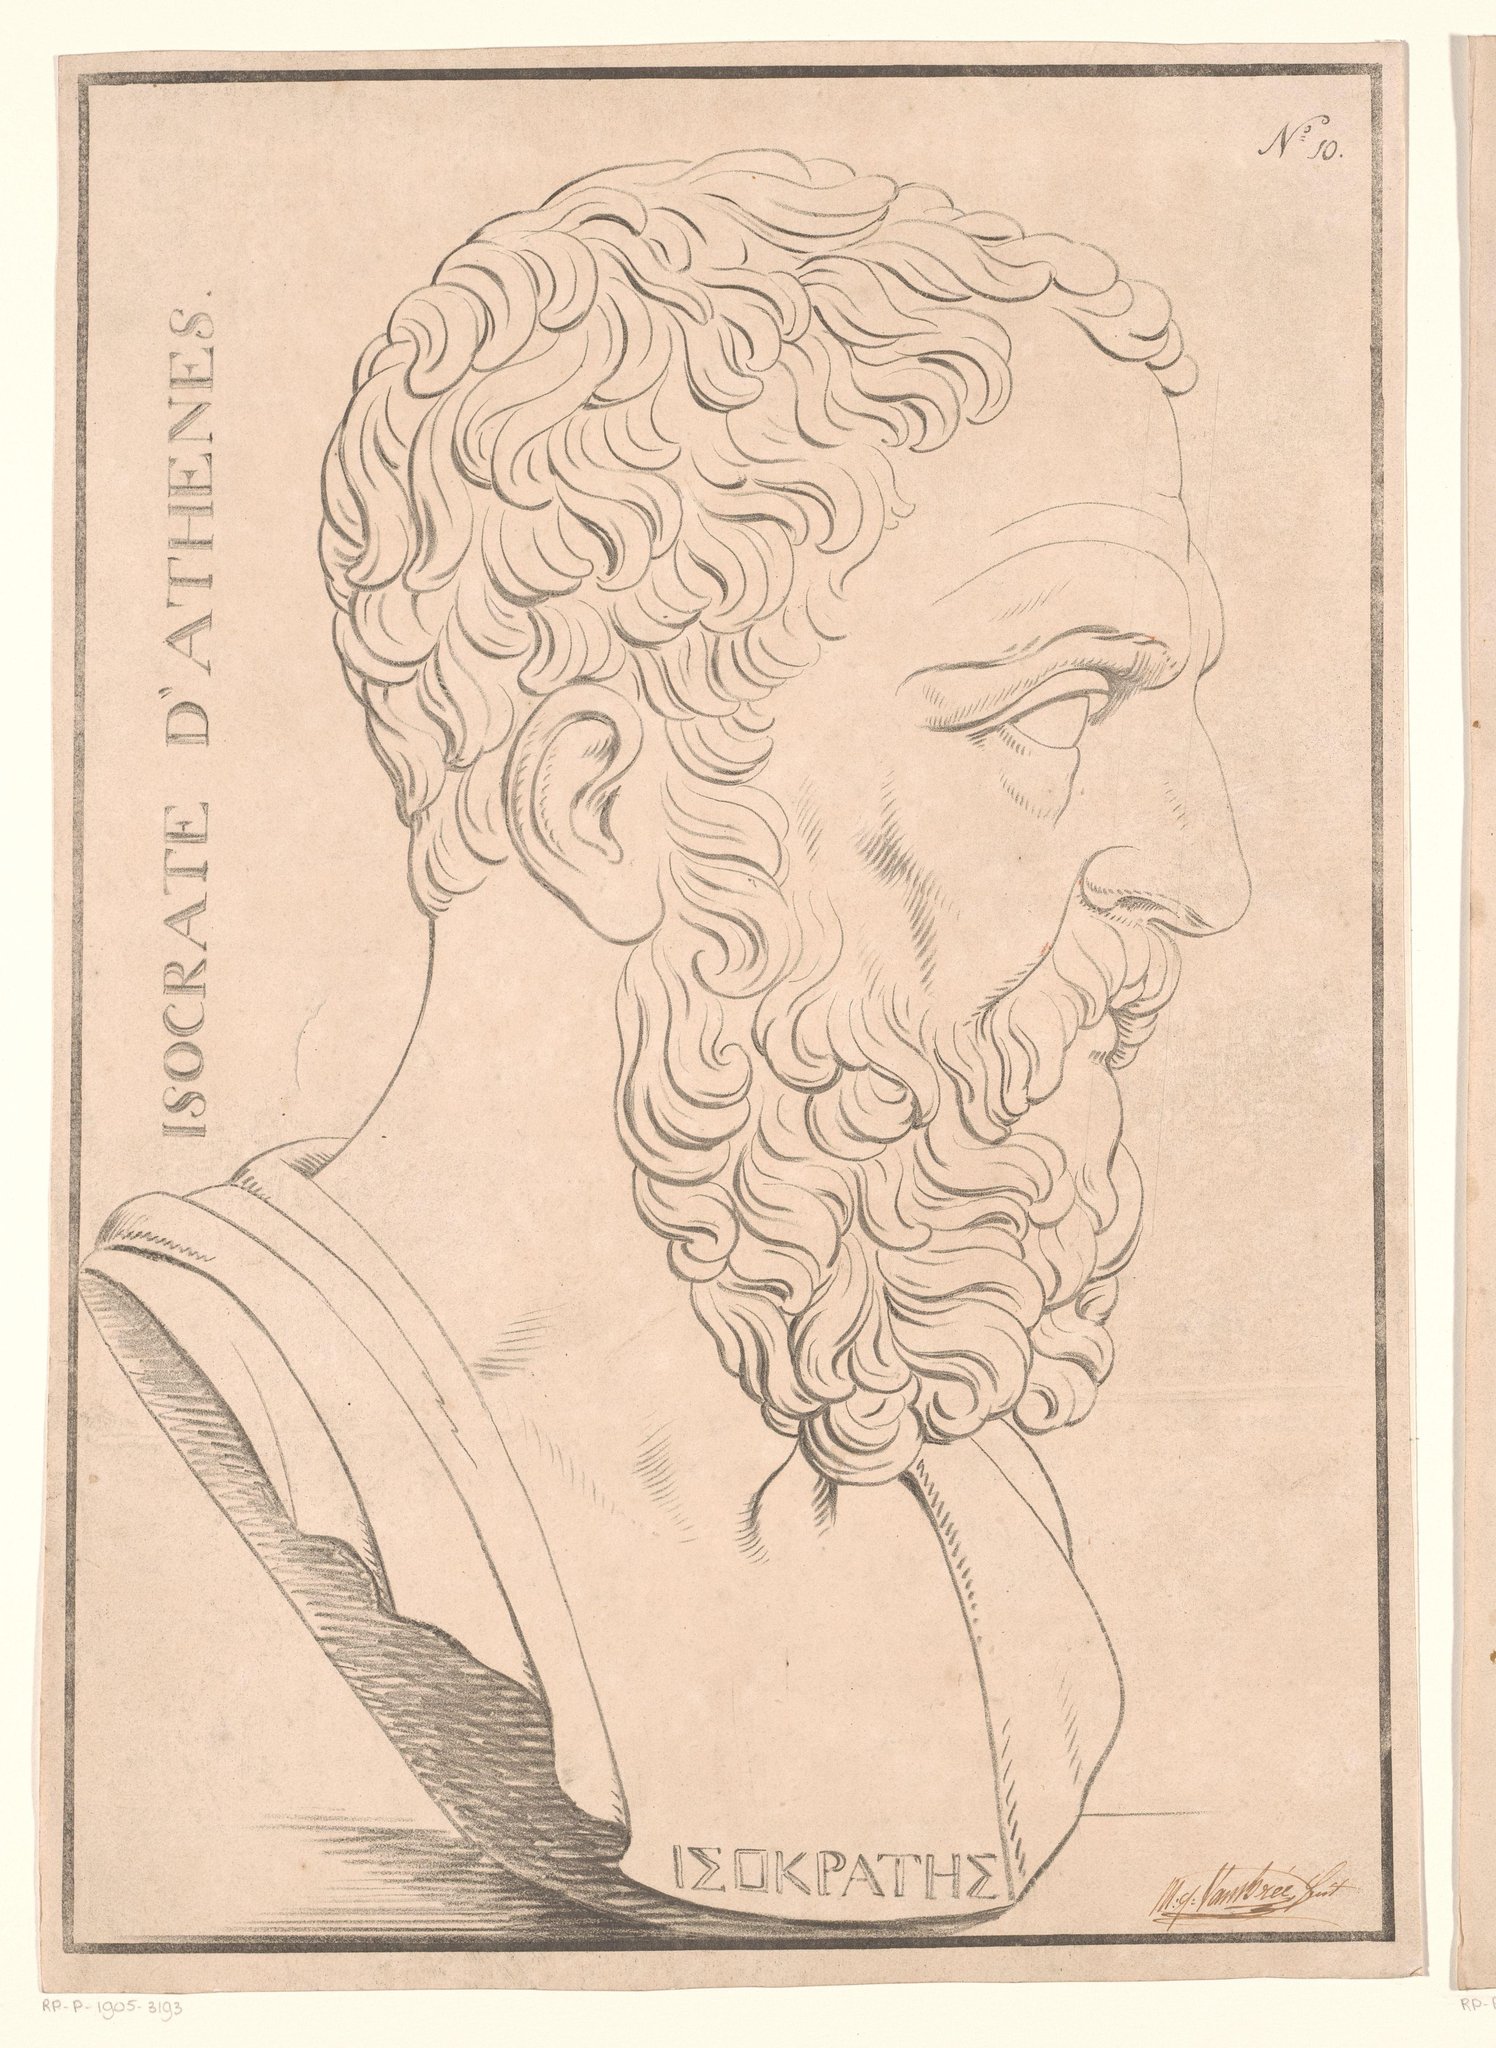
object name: print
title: Buste van Isocrates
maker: mattheus ignatius van bree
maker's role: draughtsman, print maker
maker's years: 1773-1839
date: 1809-1839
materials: paper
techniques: lithograph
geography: antwerp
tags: male persons from classical history (isocrates)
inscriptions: collector's mark: Lugt 2228